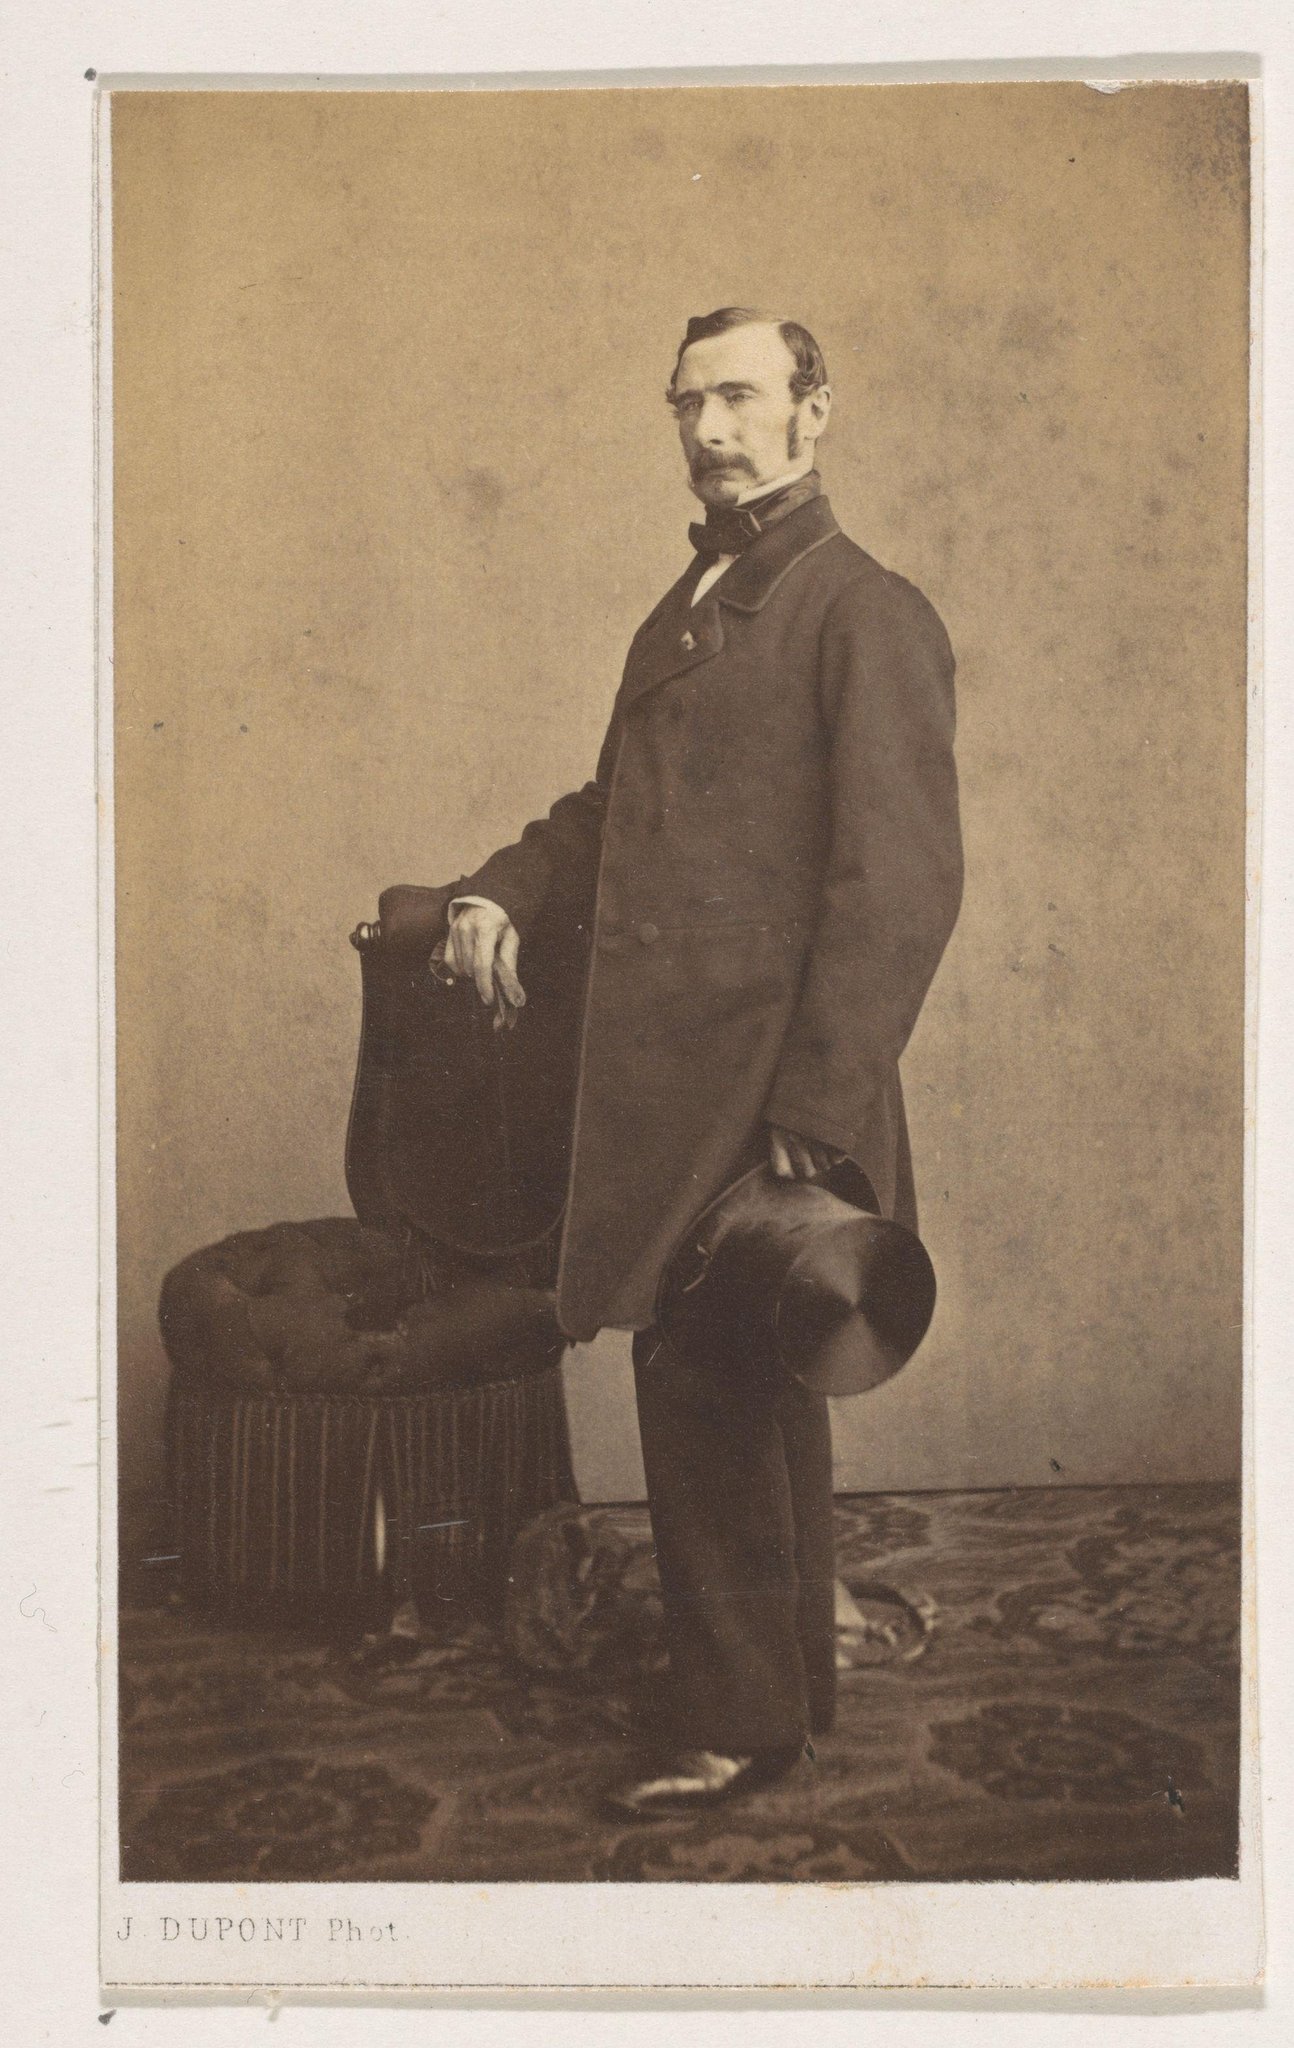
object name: carte de visite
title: L'École d'Anvers. Portraits biographies cartes de visite. Collection Dupont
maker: joseph dupont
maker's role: fotograaf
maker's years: 1818-1901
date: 1861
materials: cardboard, paper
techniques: albumen print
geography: antwerp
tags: paris, erin corr, historical persons, portrait, self-portrait of painter, portrait, self-portrait of artist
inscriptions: inscription: ‘ETABLISSEMENT PHOTOGRAPHIQUE/ de/ J. DUPONT/ Place de Meir 32/ ANVERS/ Maison fondée en 1853’